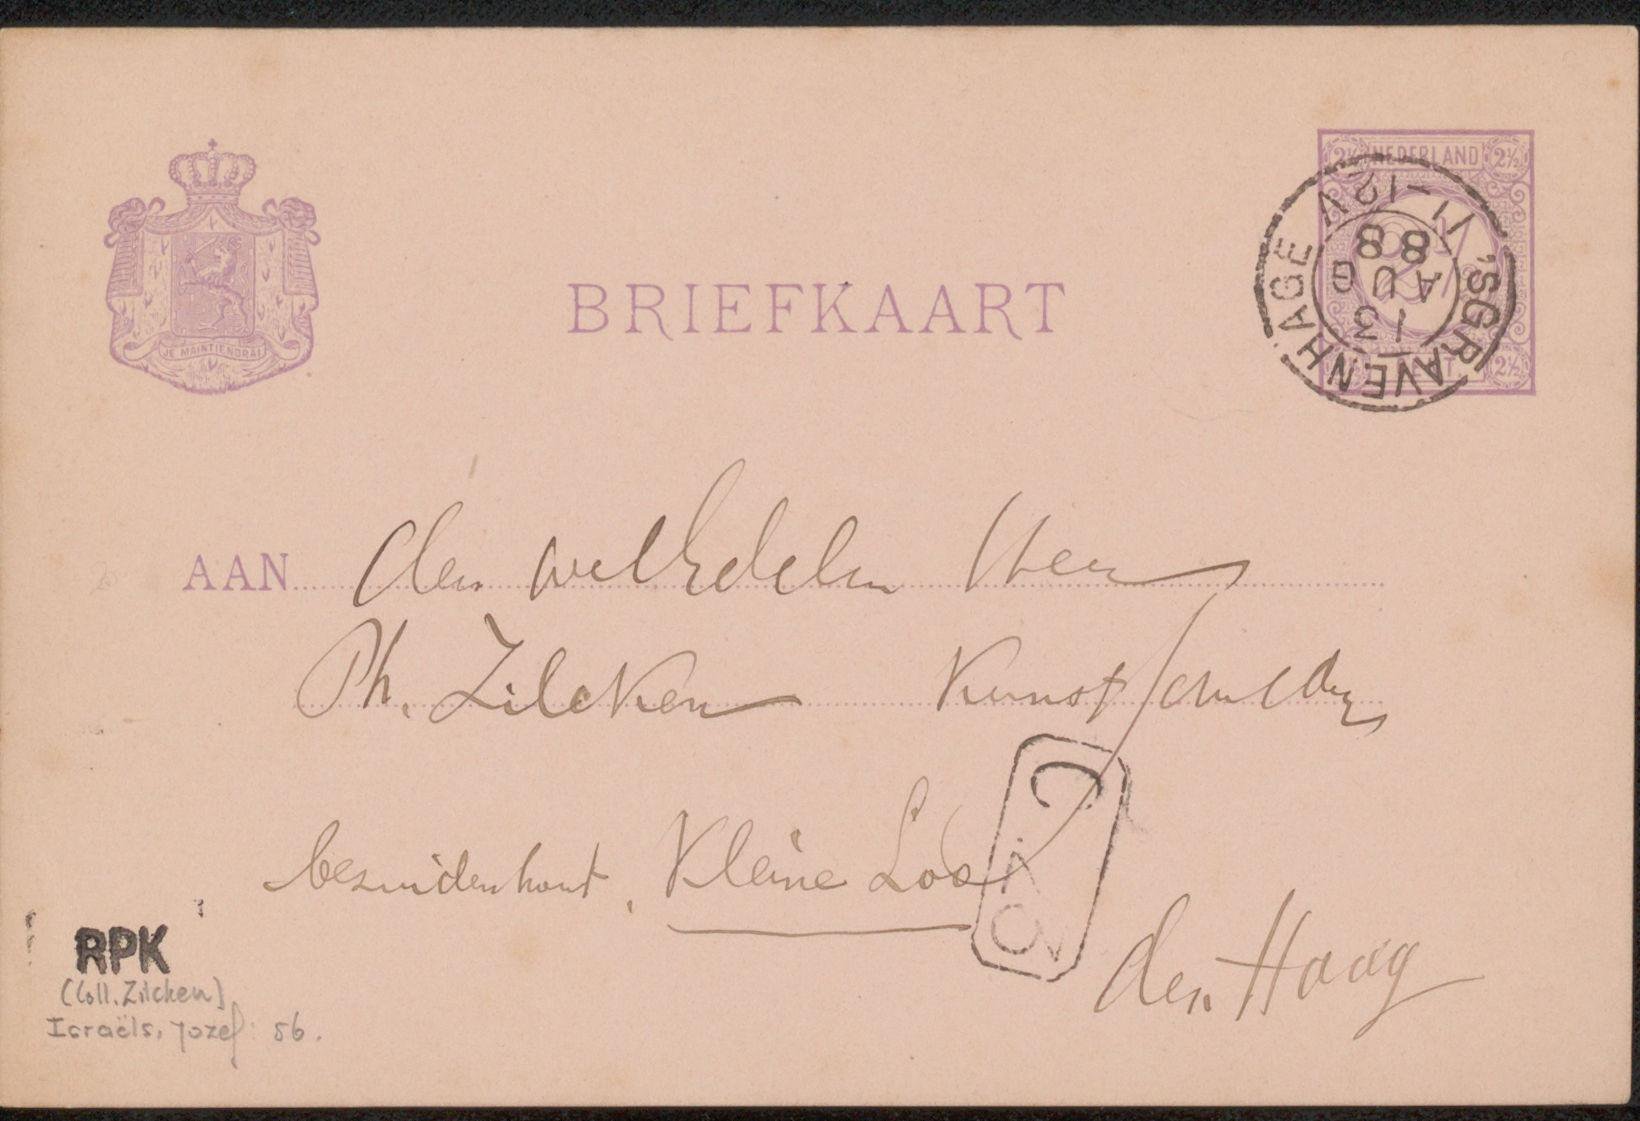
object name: postcard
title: Briefkaart aan Philip Zilcken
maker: jozef israëls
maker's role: draughtsman, painter, print maker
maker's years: 1824-1911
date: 1888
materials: cardboard, ink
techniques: pen, writing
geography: the hague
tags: philip zilcken, drawing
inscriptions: collector's mark: ‘RPK’